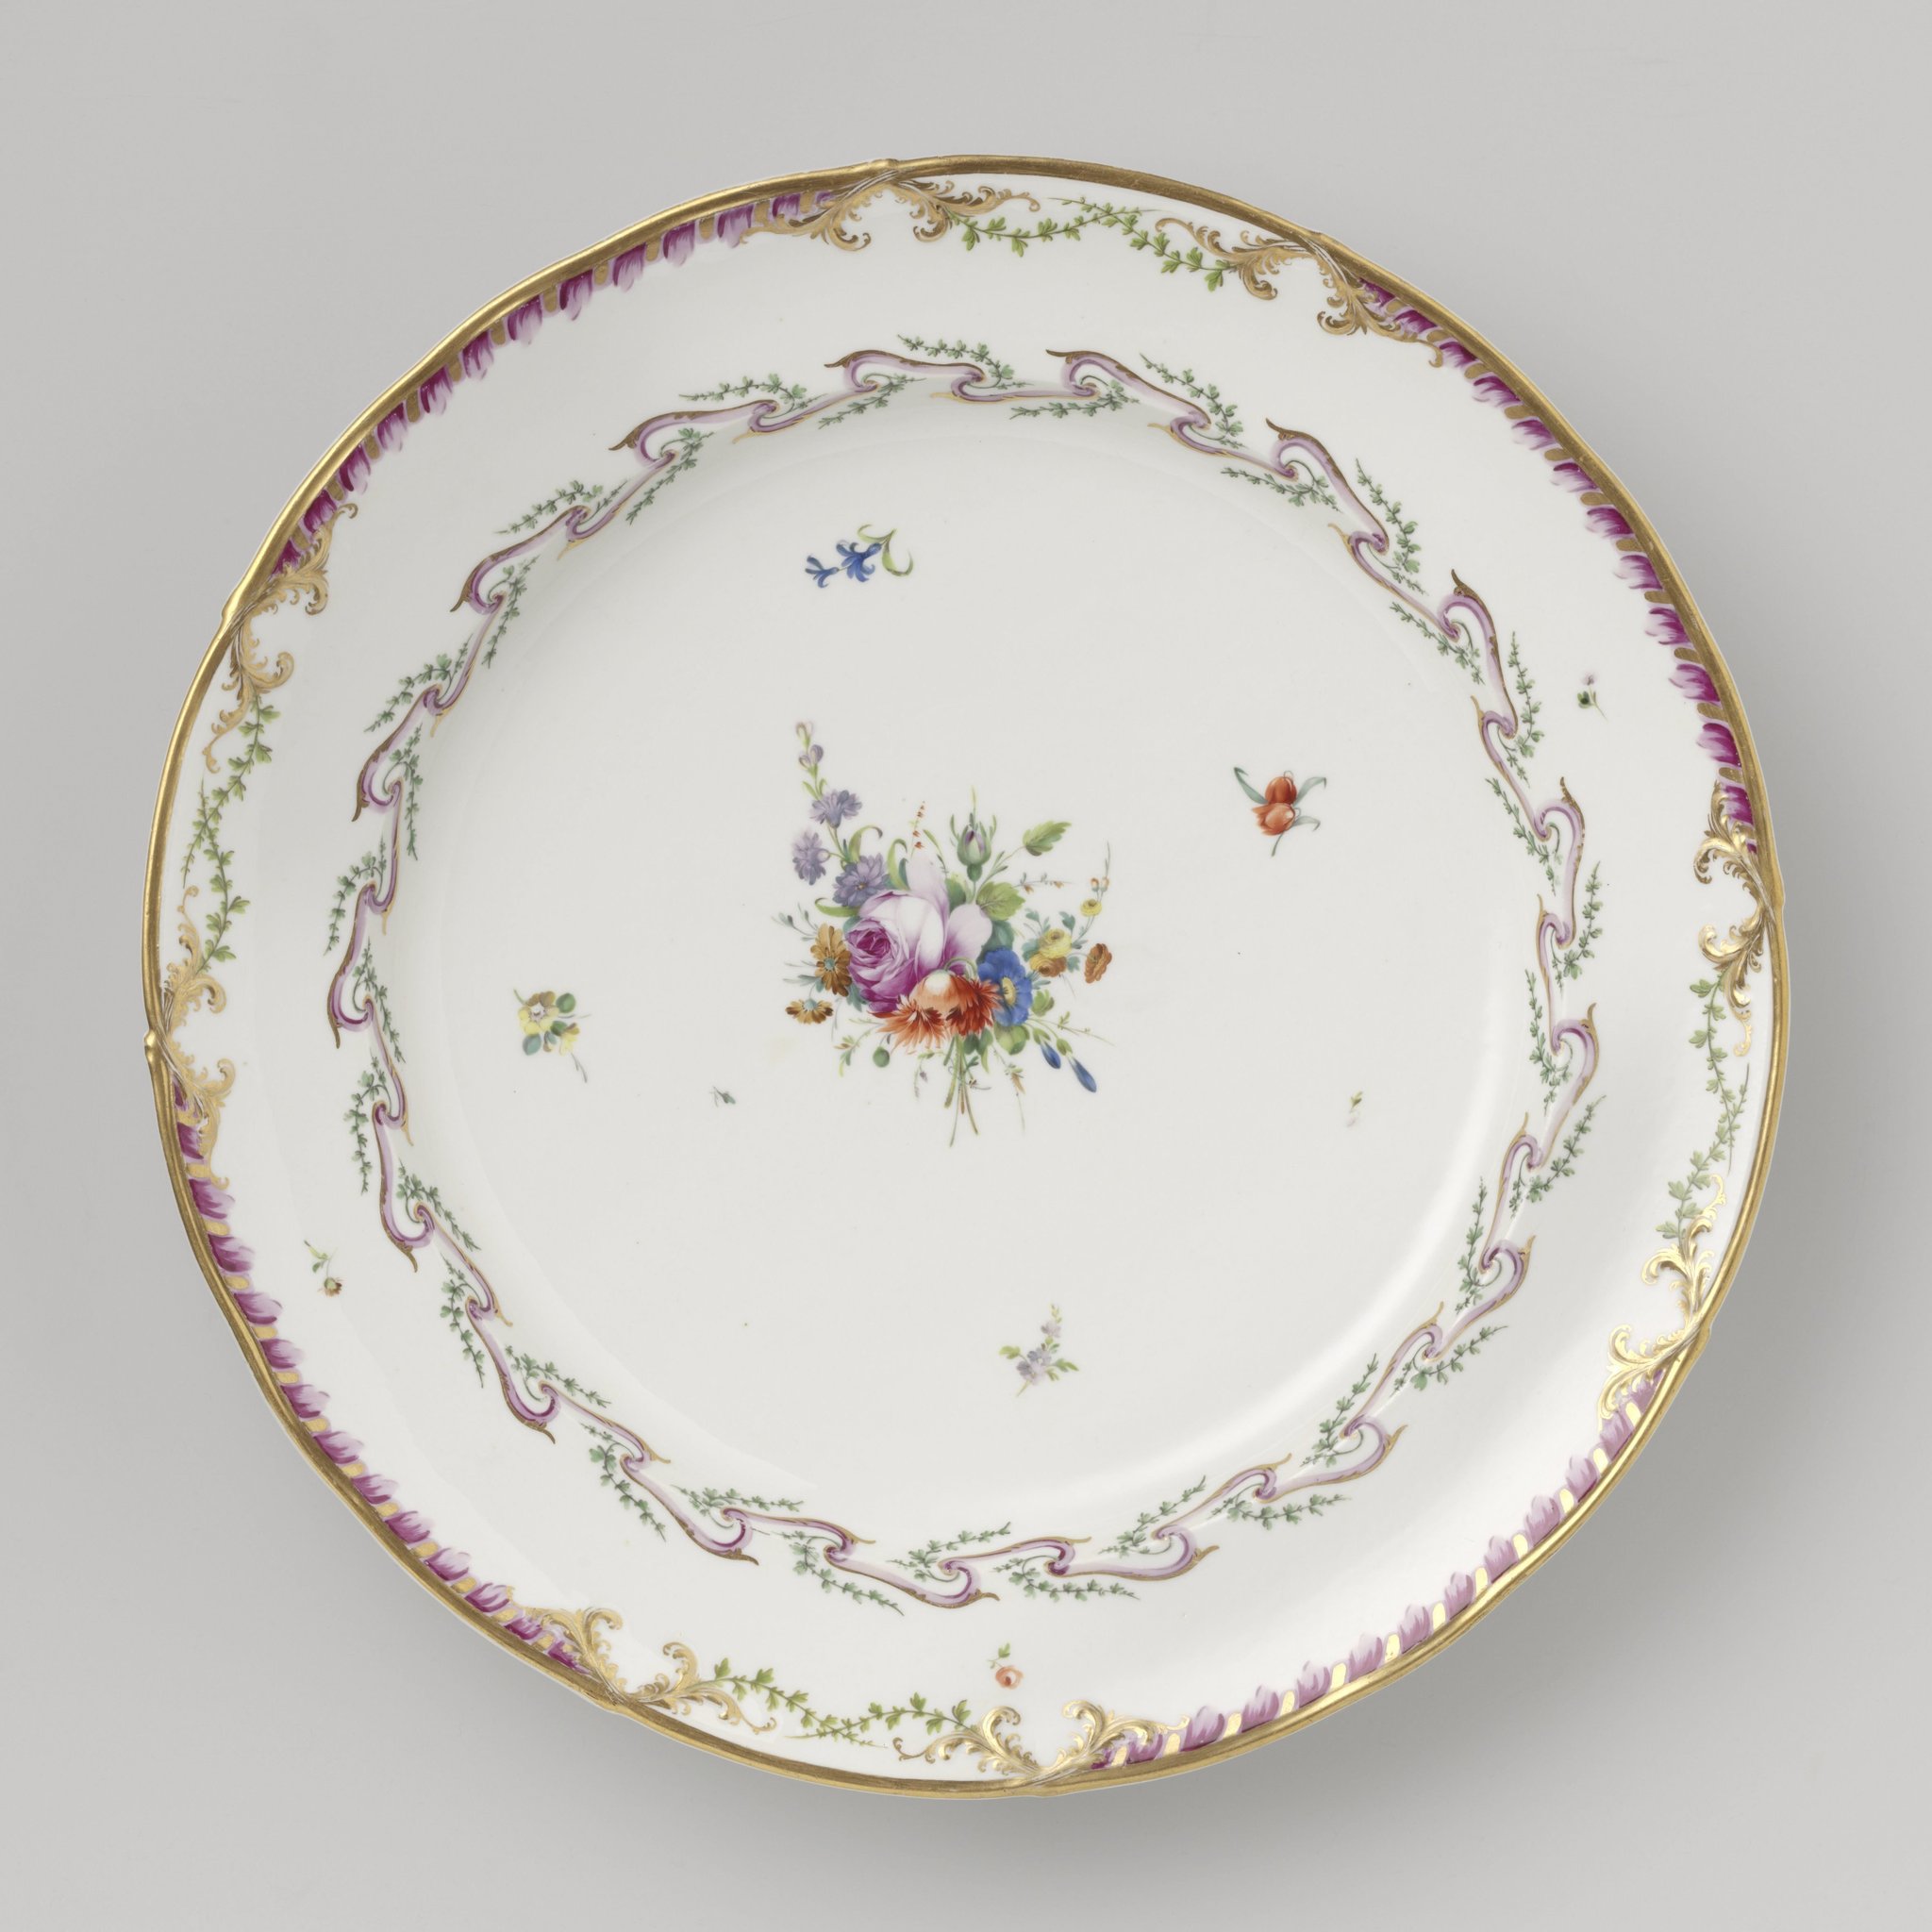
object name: platter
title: Schotel, behorend bij een servies versierd met lintmotief met bladeren, bloemboeketten en gestrooide bloemtakken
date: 1780-1820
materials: porcelain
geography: loosdrecht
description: Schotel van porselein, behorend bij een servies van porselein versierd met een geslingerd lintmotief in paars en goud met groene bladertakken, bloemboeketten en gestrooide bloemtakken. Randen licht gegolfd, met decoratie in goud met paars bladmotief waartussen groen gekruist bladmotief. Gemerkt: M.O.L. en Amstel.